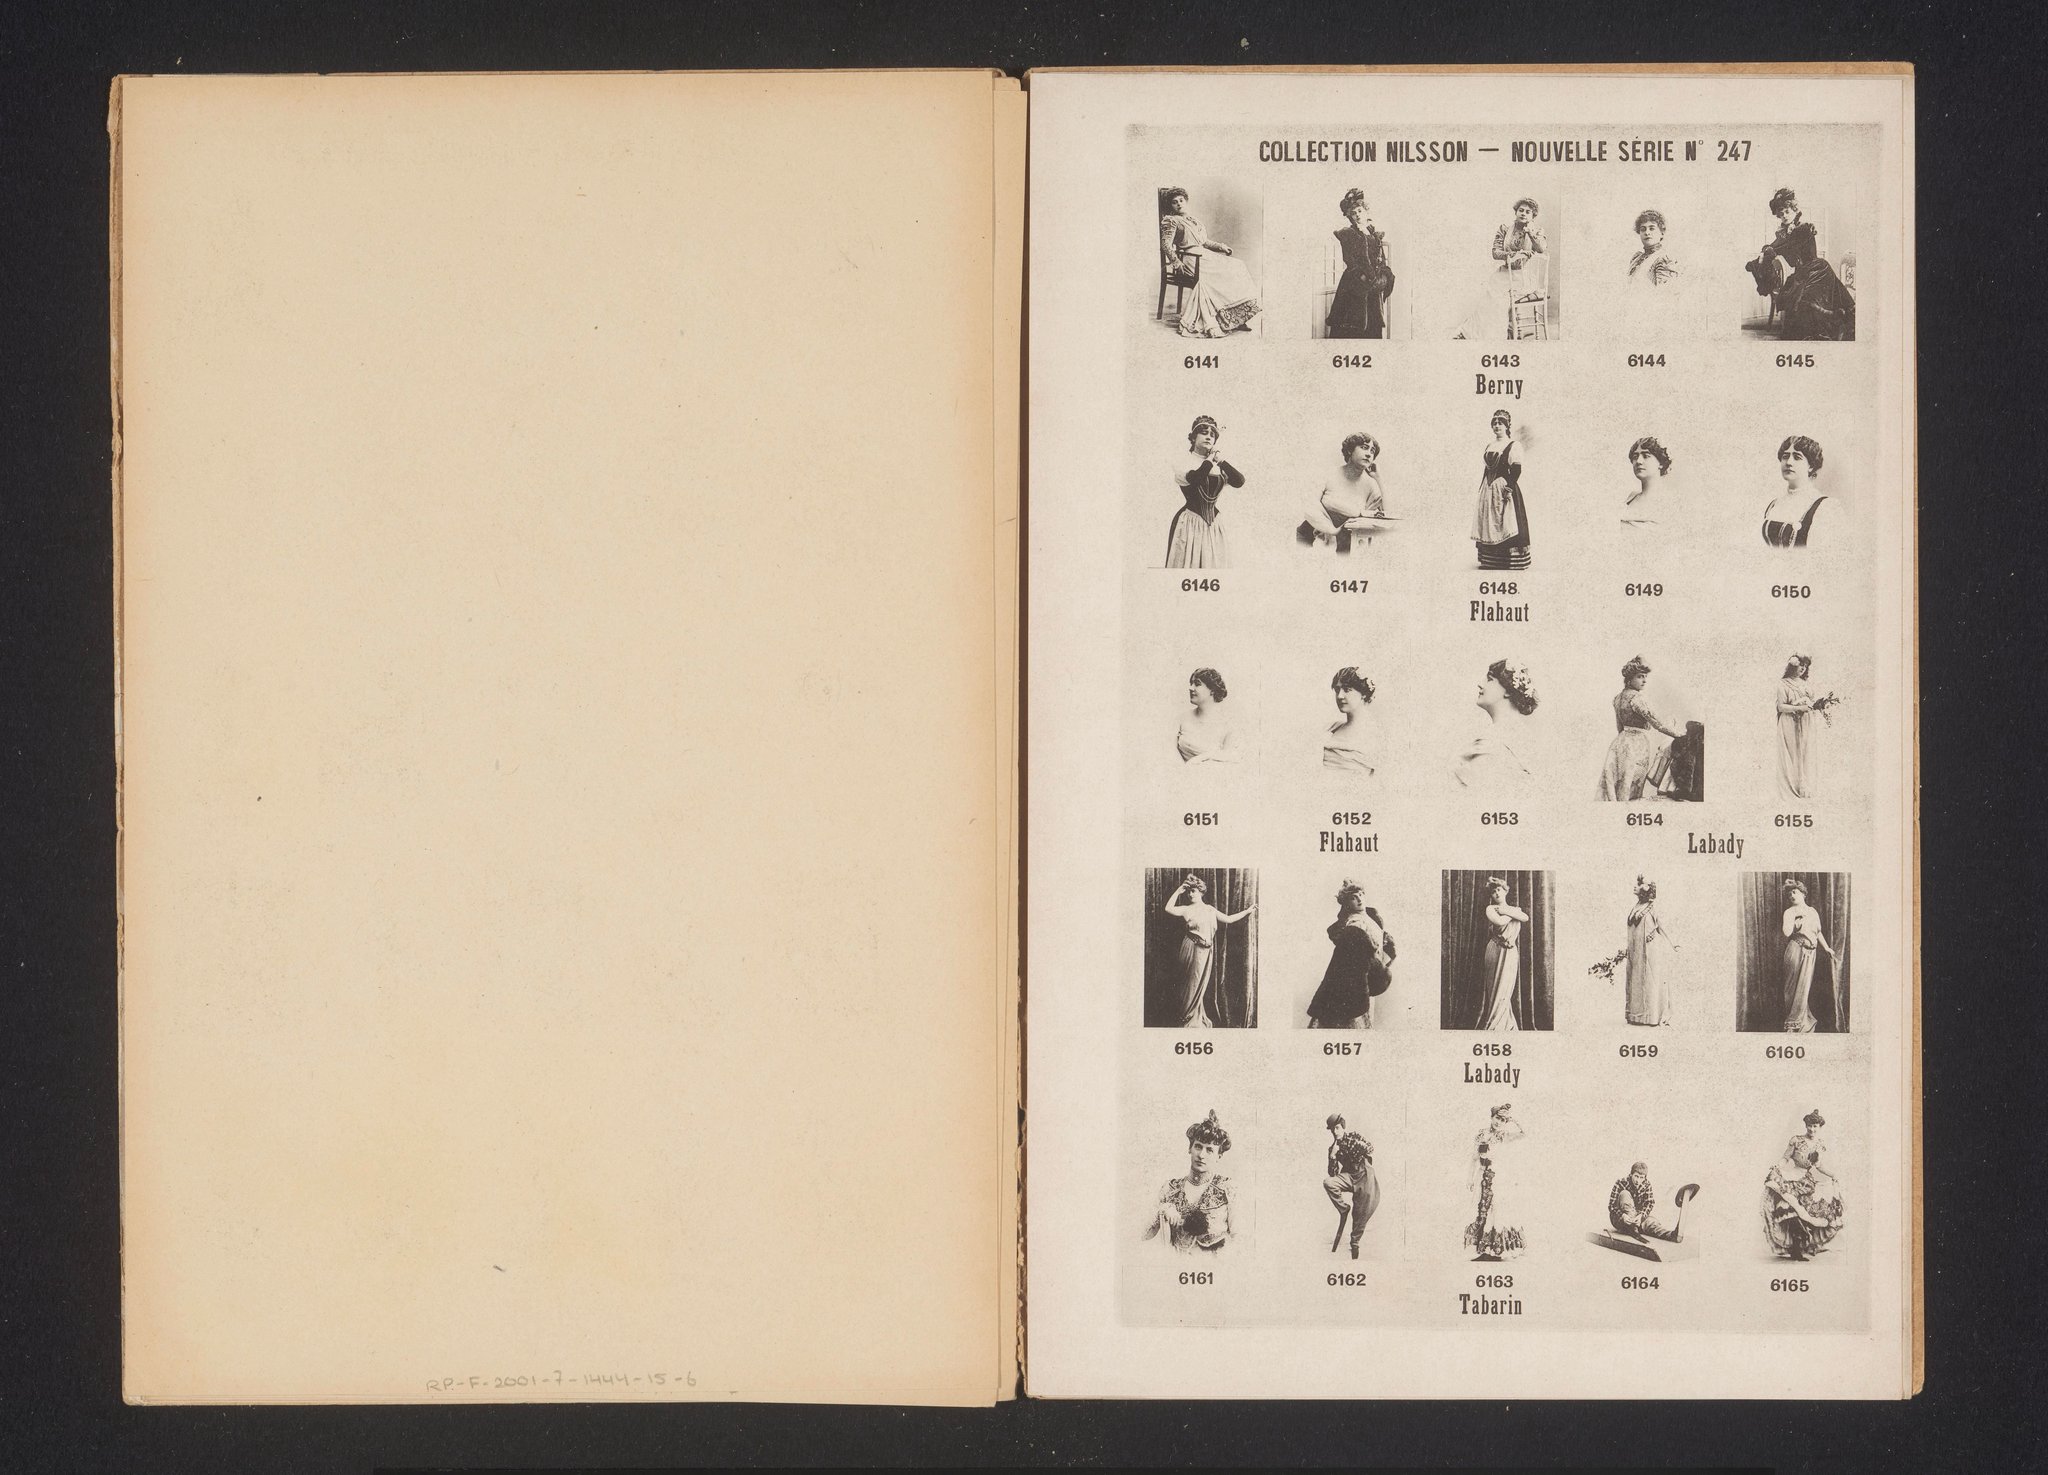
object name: photomechanical print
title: 25 portretten van Berny, Flahaut, Labady en Tabarin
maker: Anonymous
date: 1894-1899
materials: paper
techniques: photograph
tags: historical persons - bb - woman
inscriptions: number: ‘No 247’